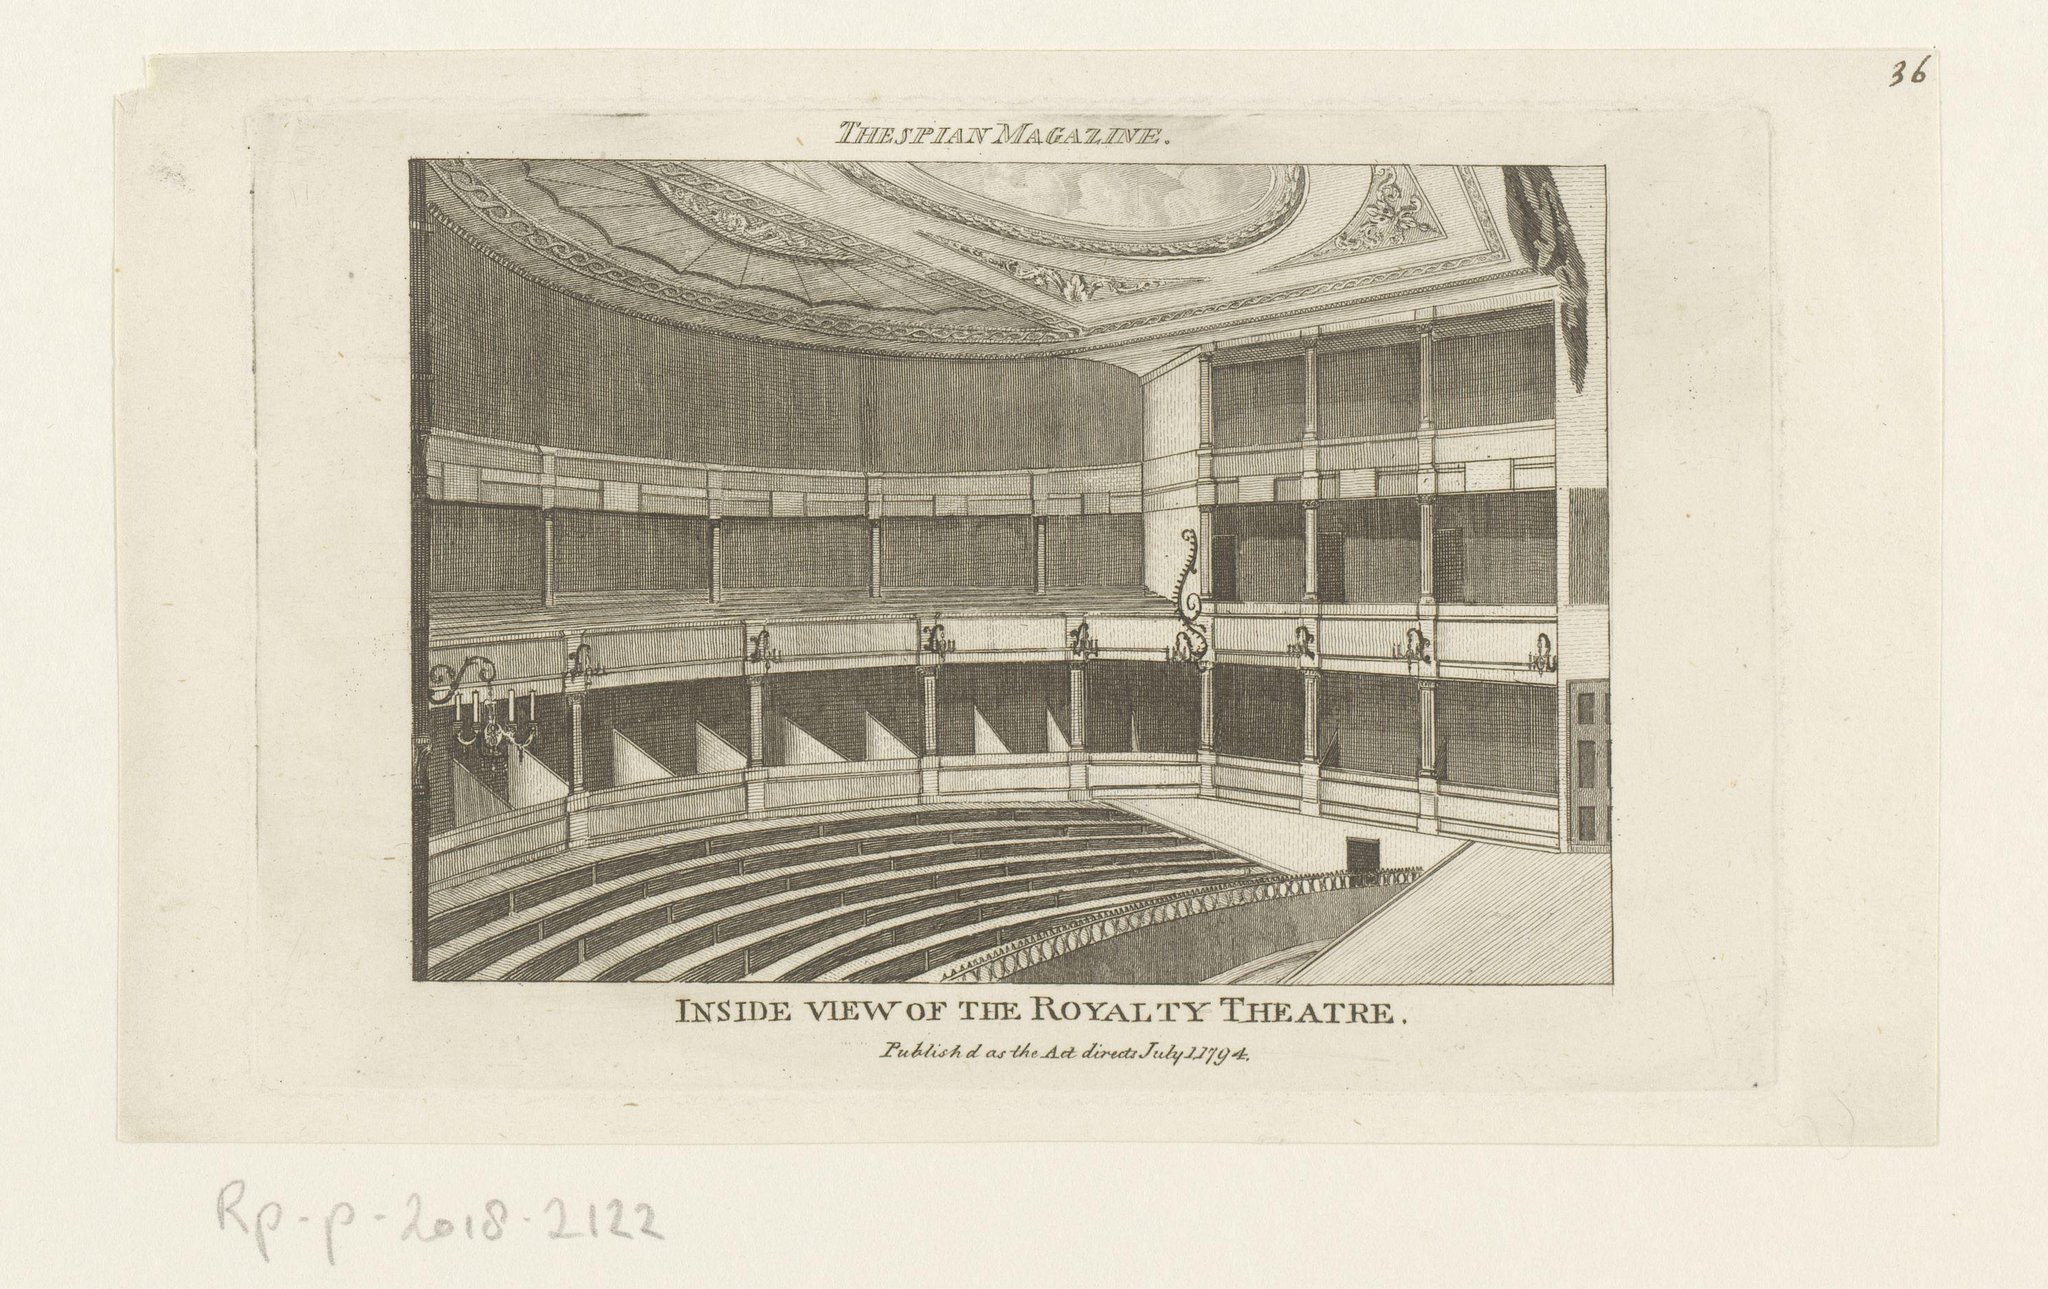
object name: print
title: Inside view of the Royalty Theatre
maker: Anonymous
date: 1794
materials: paper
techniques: etching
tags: theatre (building), london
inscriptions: collector's mark: Lugt 2228